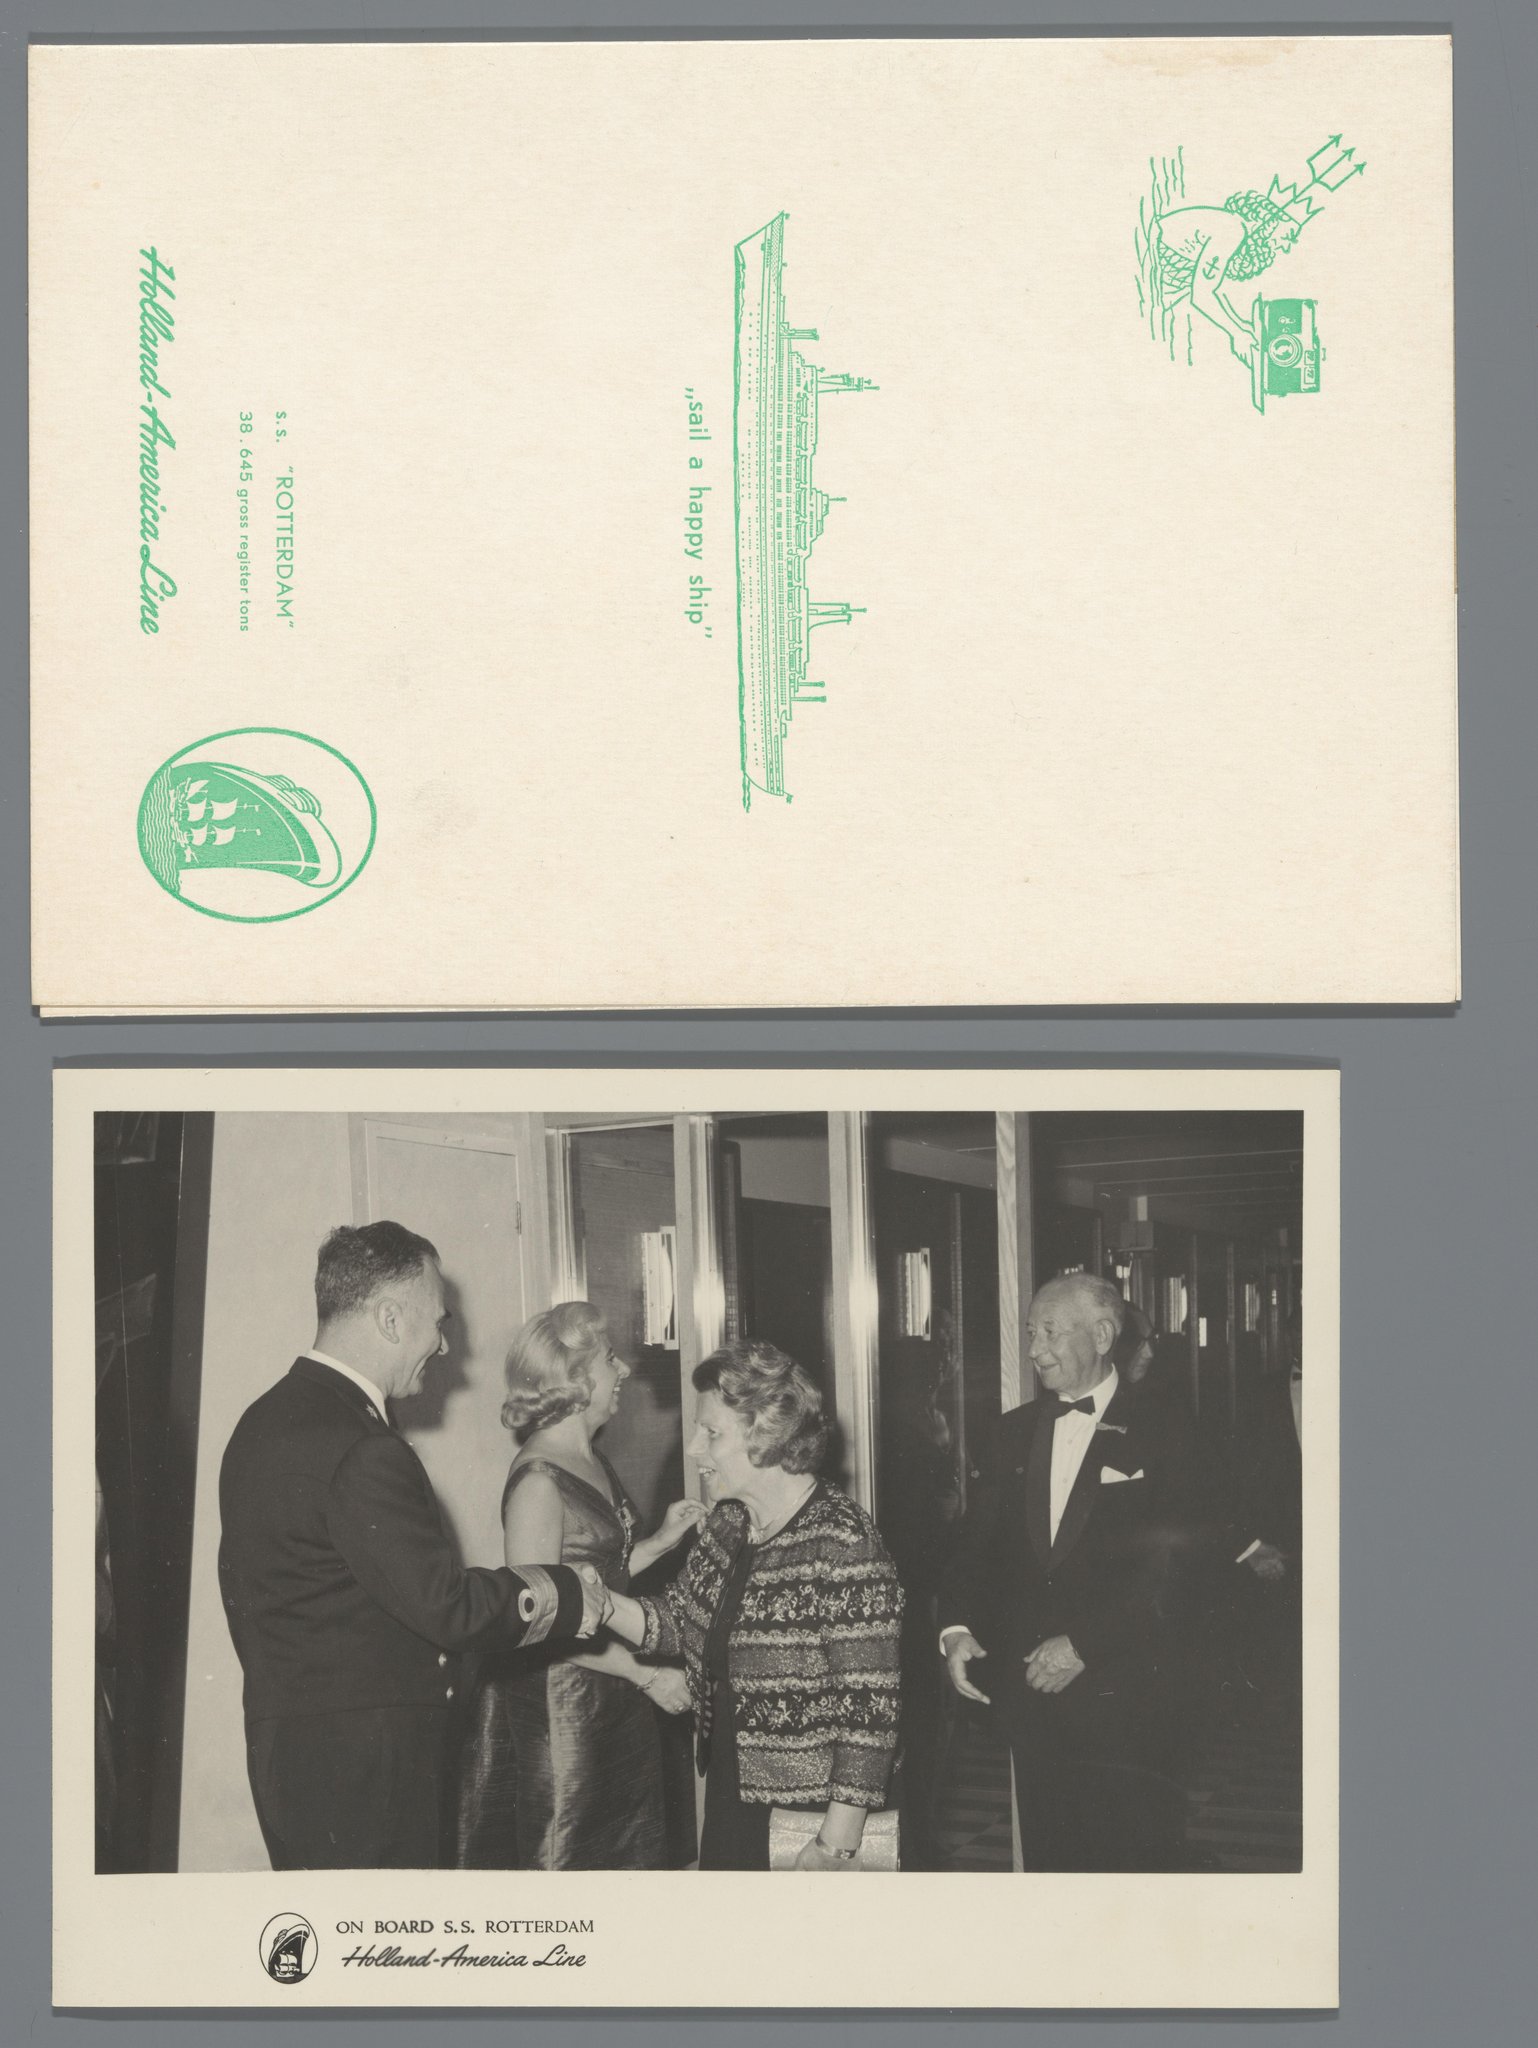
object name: wrapper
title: Sail a happy ship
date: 1959-1980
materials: paper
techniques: letterpress printing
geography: rotterdam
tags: ship's portrait, camera ~ photography, neptune as lord of the sea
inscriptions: inscription: ‘Memories of a pleasant voyage/ on board of/ Holland's greatest ship’, inscription: ‘Cabin Nr. Receipt Nr./ Name/ Class/ Photo/ John Mulder/ s.s. "Rotterdam" (...)’, inscription: ‘"Sail a happy ship"/ s.s. "Rotterdam"/ 38.645 gross register tons/ Holland-America Line’